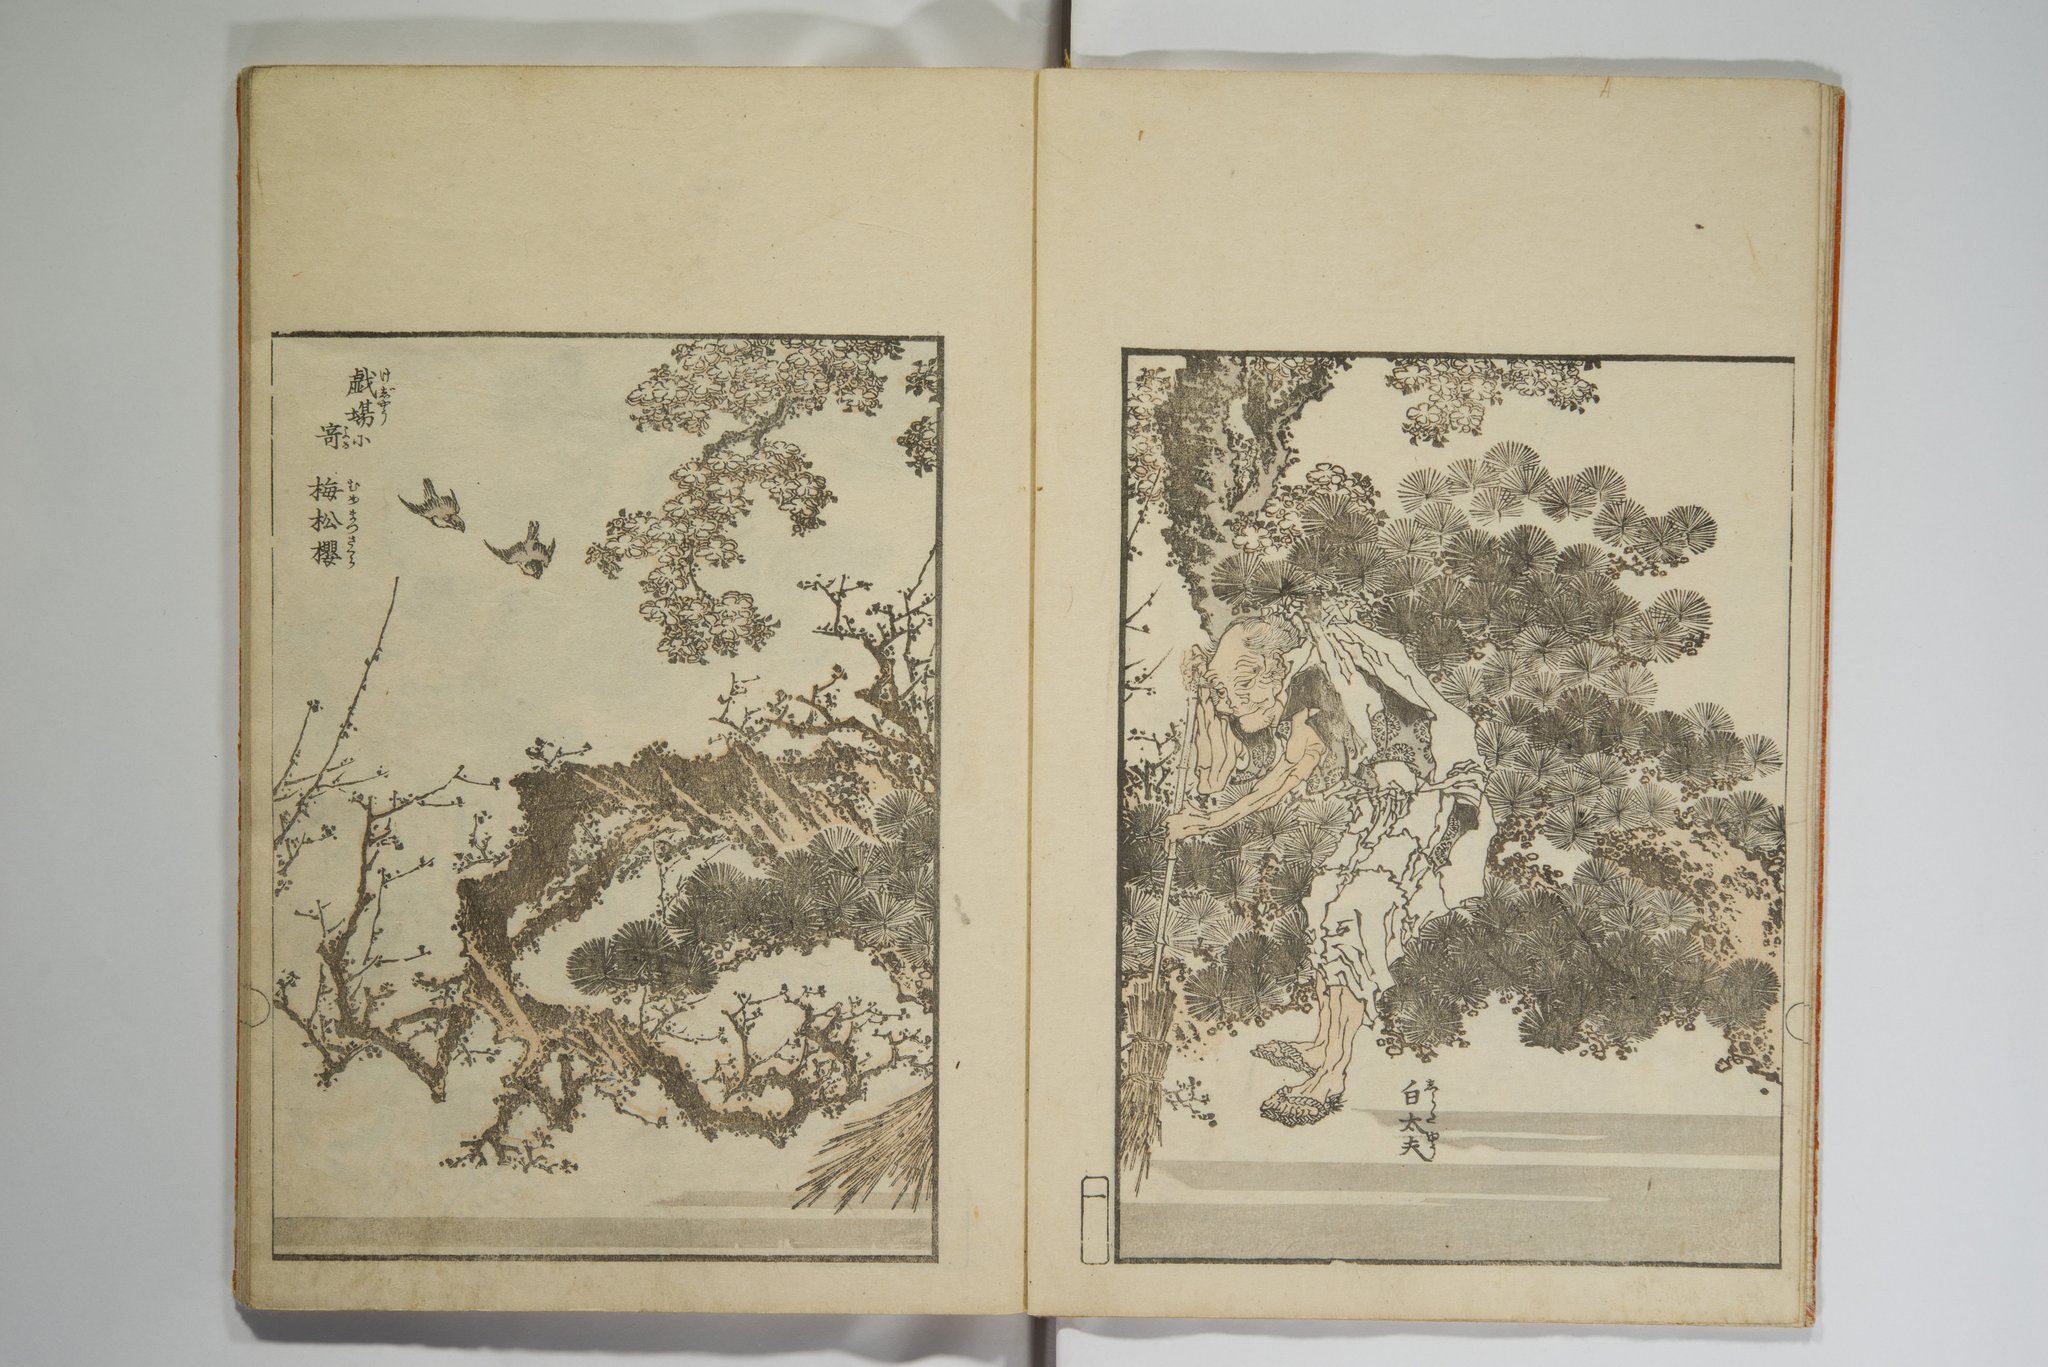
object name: illustrated book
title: Picture Album Transmitting the Spirit: The Hokusai Drawing Style (Denshin gafu Hokusai gashiki)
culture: japanese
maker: katsushika hokusai 葛飾北斎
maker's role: artist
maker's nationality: japanese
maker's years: 1760-1849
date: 1819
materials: ink, paper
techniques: woodblock print